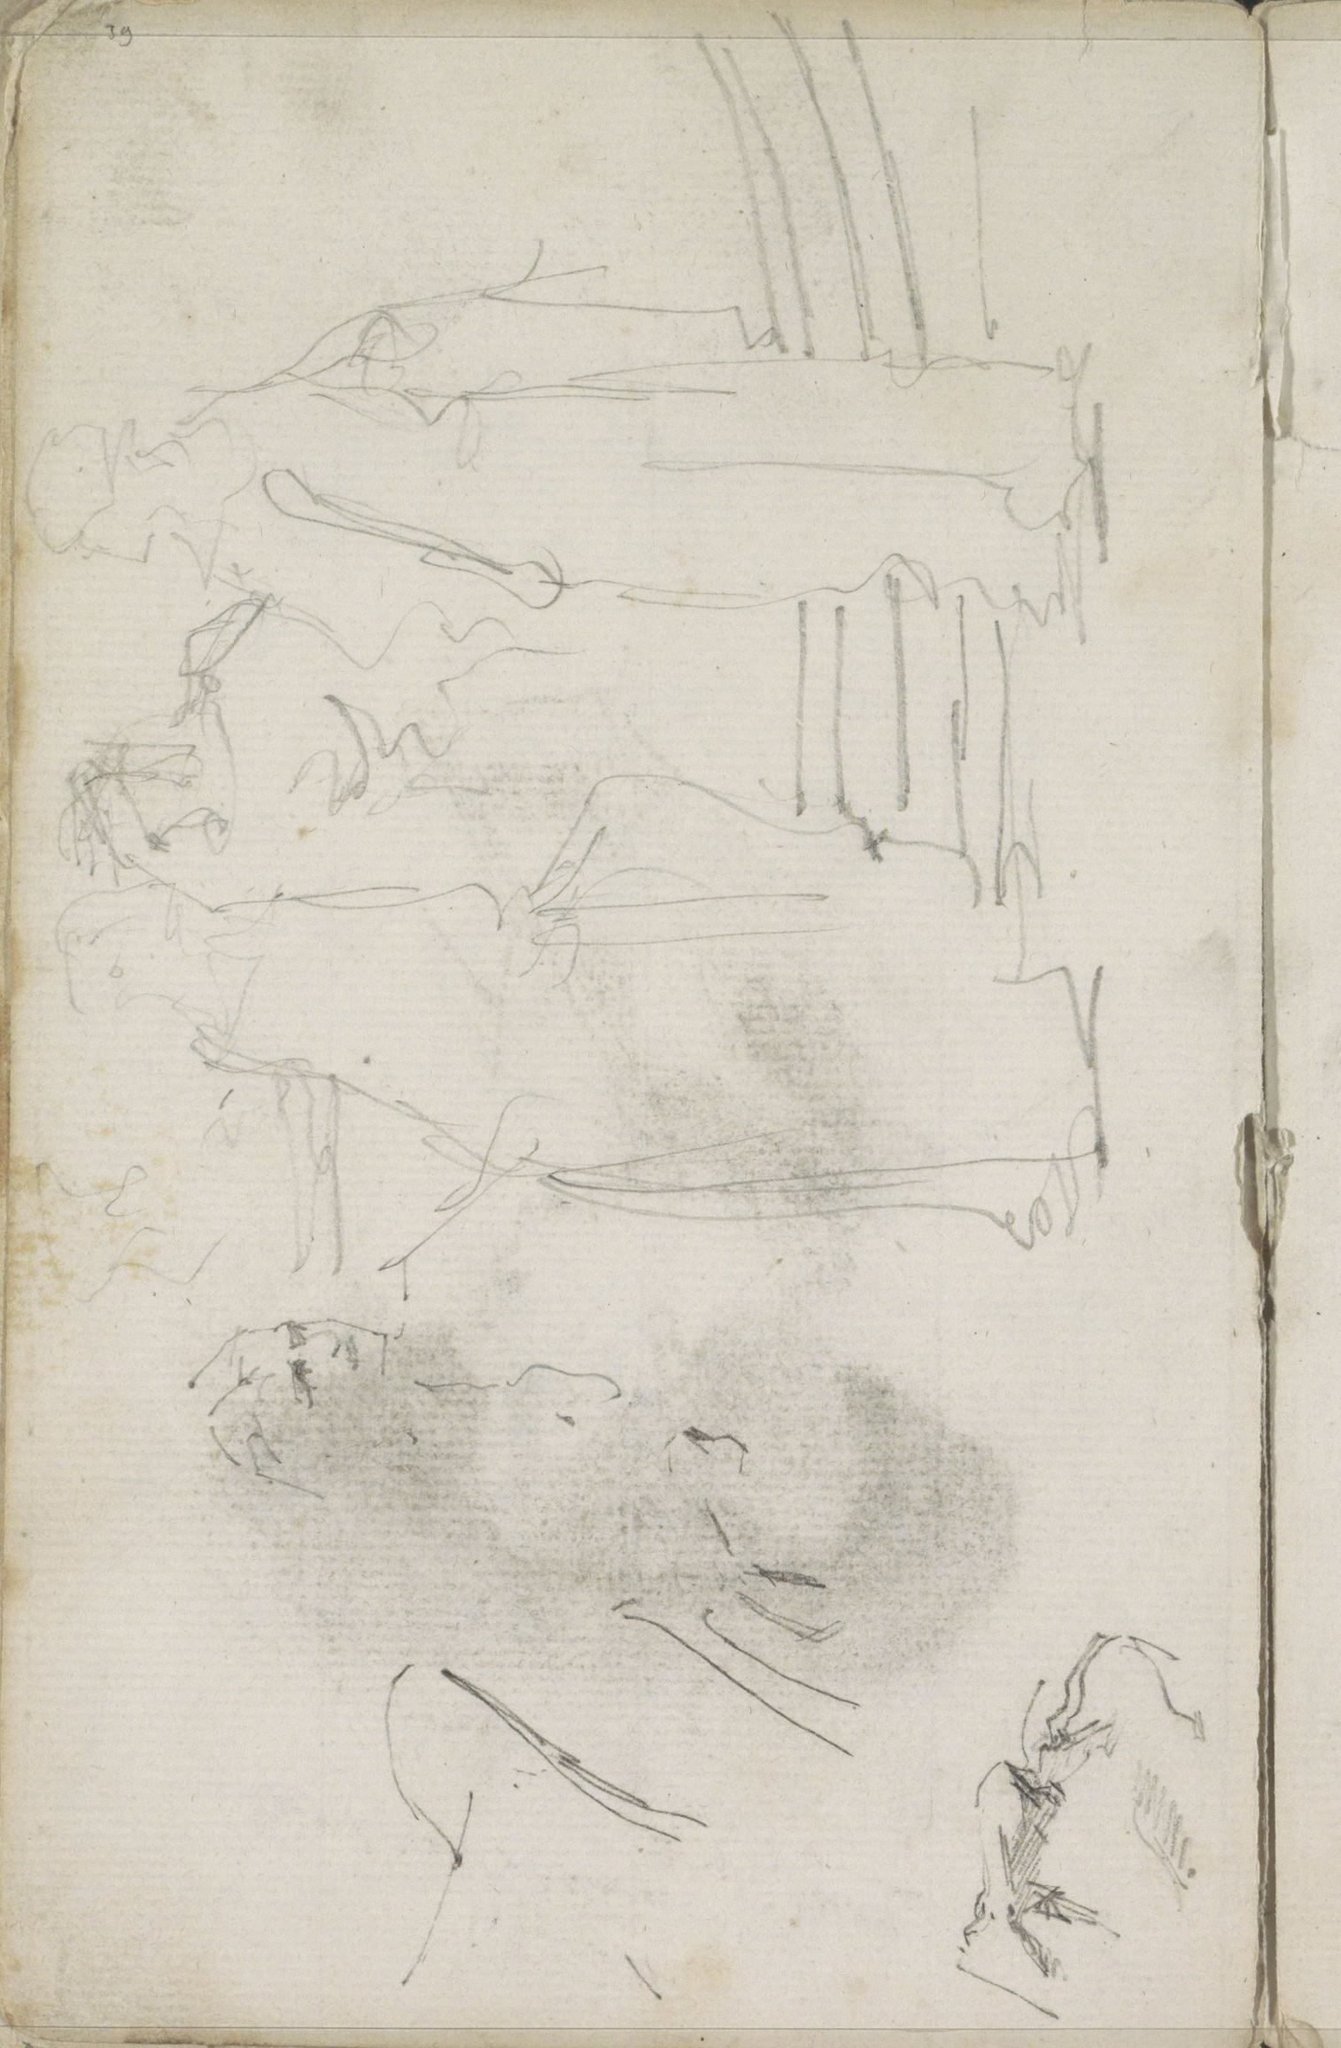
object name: sketchbook leaf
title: Studieblad met vrouwen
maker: george hendrik breitner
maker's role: draughtsman, painter, print maker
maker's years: 1857-1923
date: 1880-1882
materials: chalk, paper, pencil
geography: the hague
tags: adult woman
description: Pagina 39 uit een schetsboek met 29 bladen.